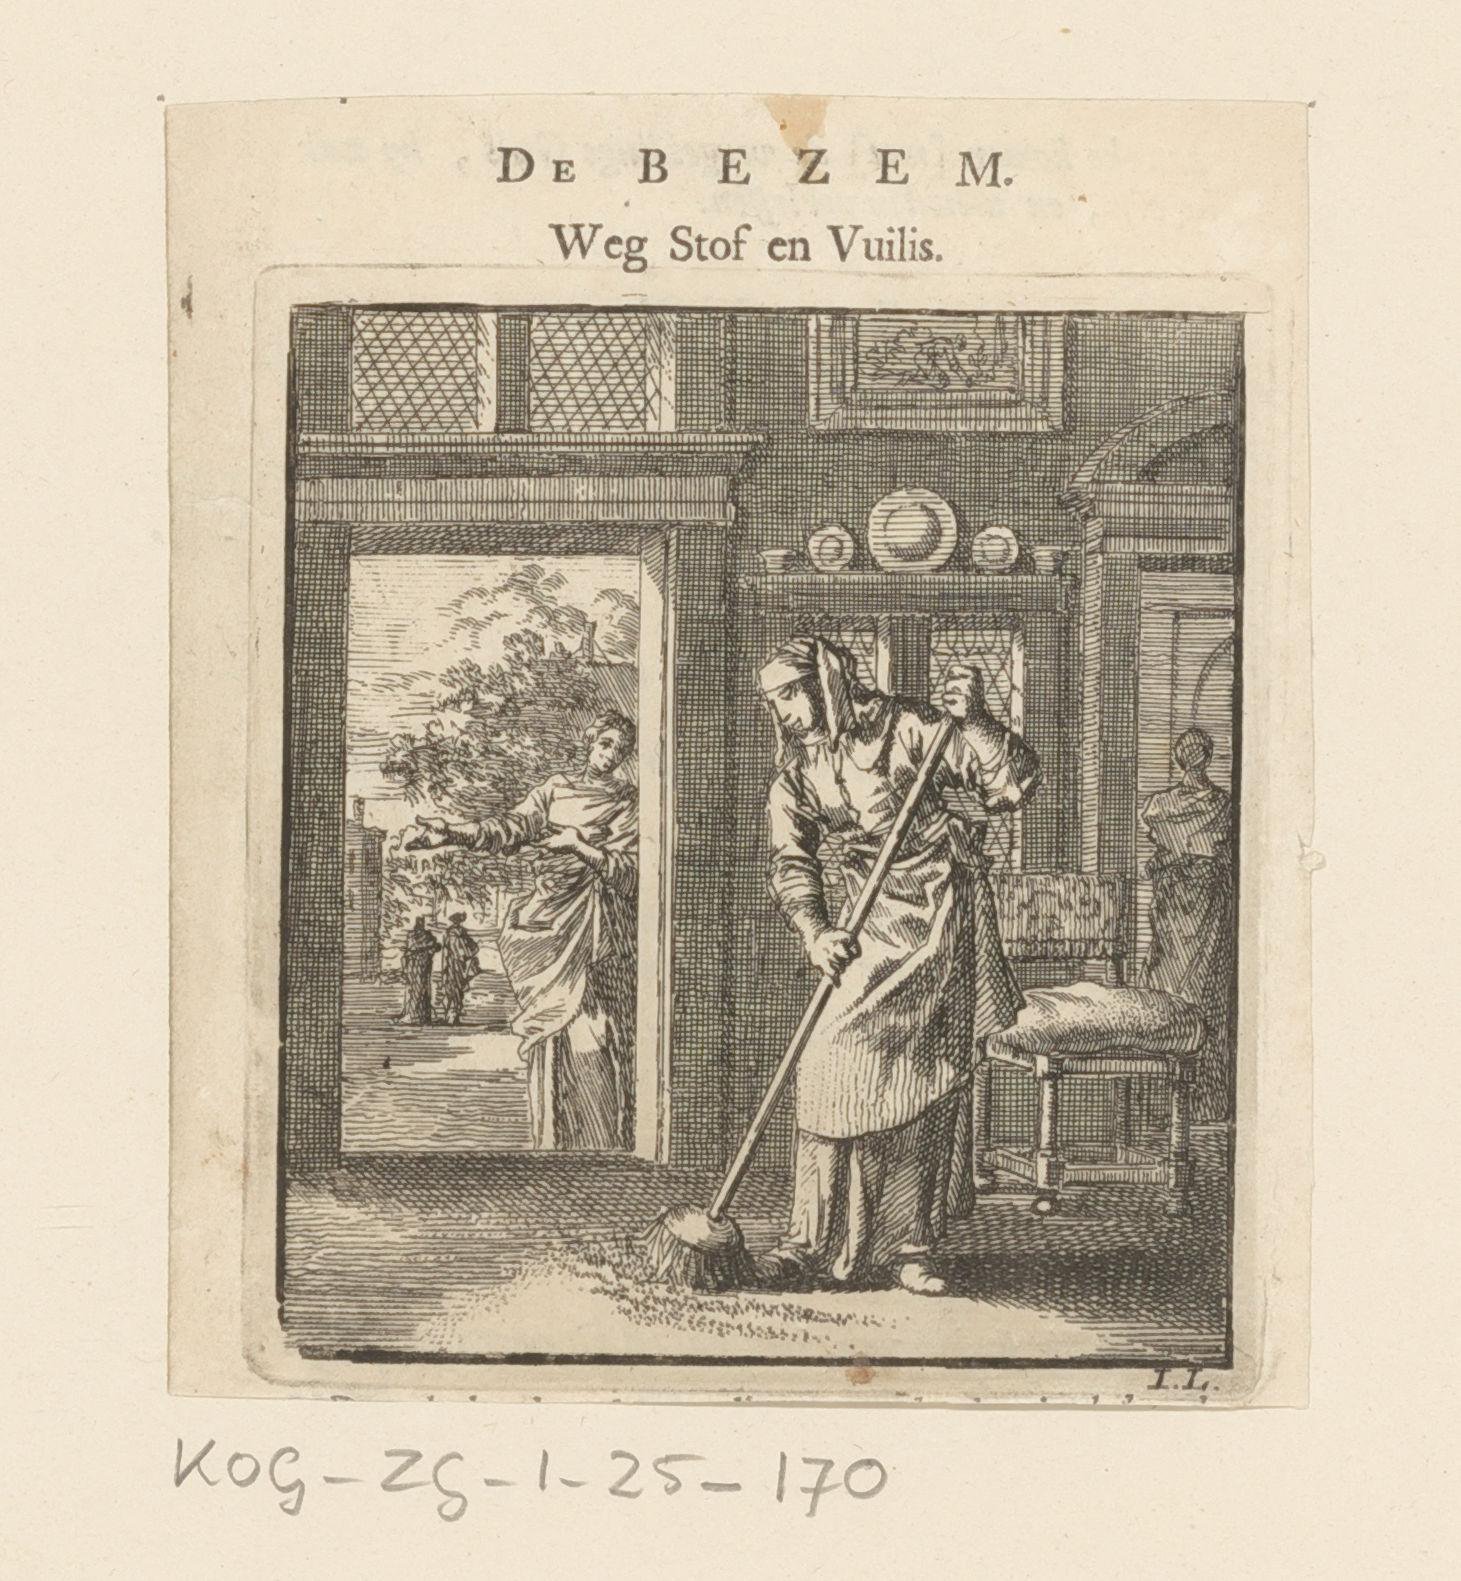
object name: book illustration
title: De Bezem. Weg Stof en Vuilis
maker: jan luyken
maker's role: draughtsman, print maker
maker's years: 1649-1712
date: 1711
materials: paper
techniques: etching, letterpress printing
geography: amsterdam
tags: shrubs: broom, sweeping (~ cleaning the house)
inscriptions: collector's mark: Lugt 1641, stamp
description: Prent uit: Luyken, Jan. Het leerzaam huisraad, vertoond in vyftig konstige figuuren, met godlyke spreuken en stichtelyke verzen. Amsterdam: weduwe Pieter Arentsz. II en Cornelis van der Sys, 1711, p. 146.